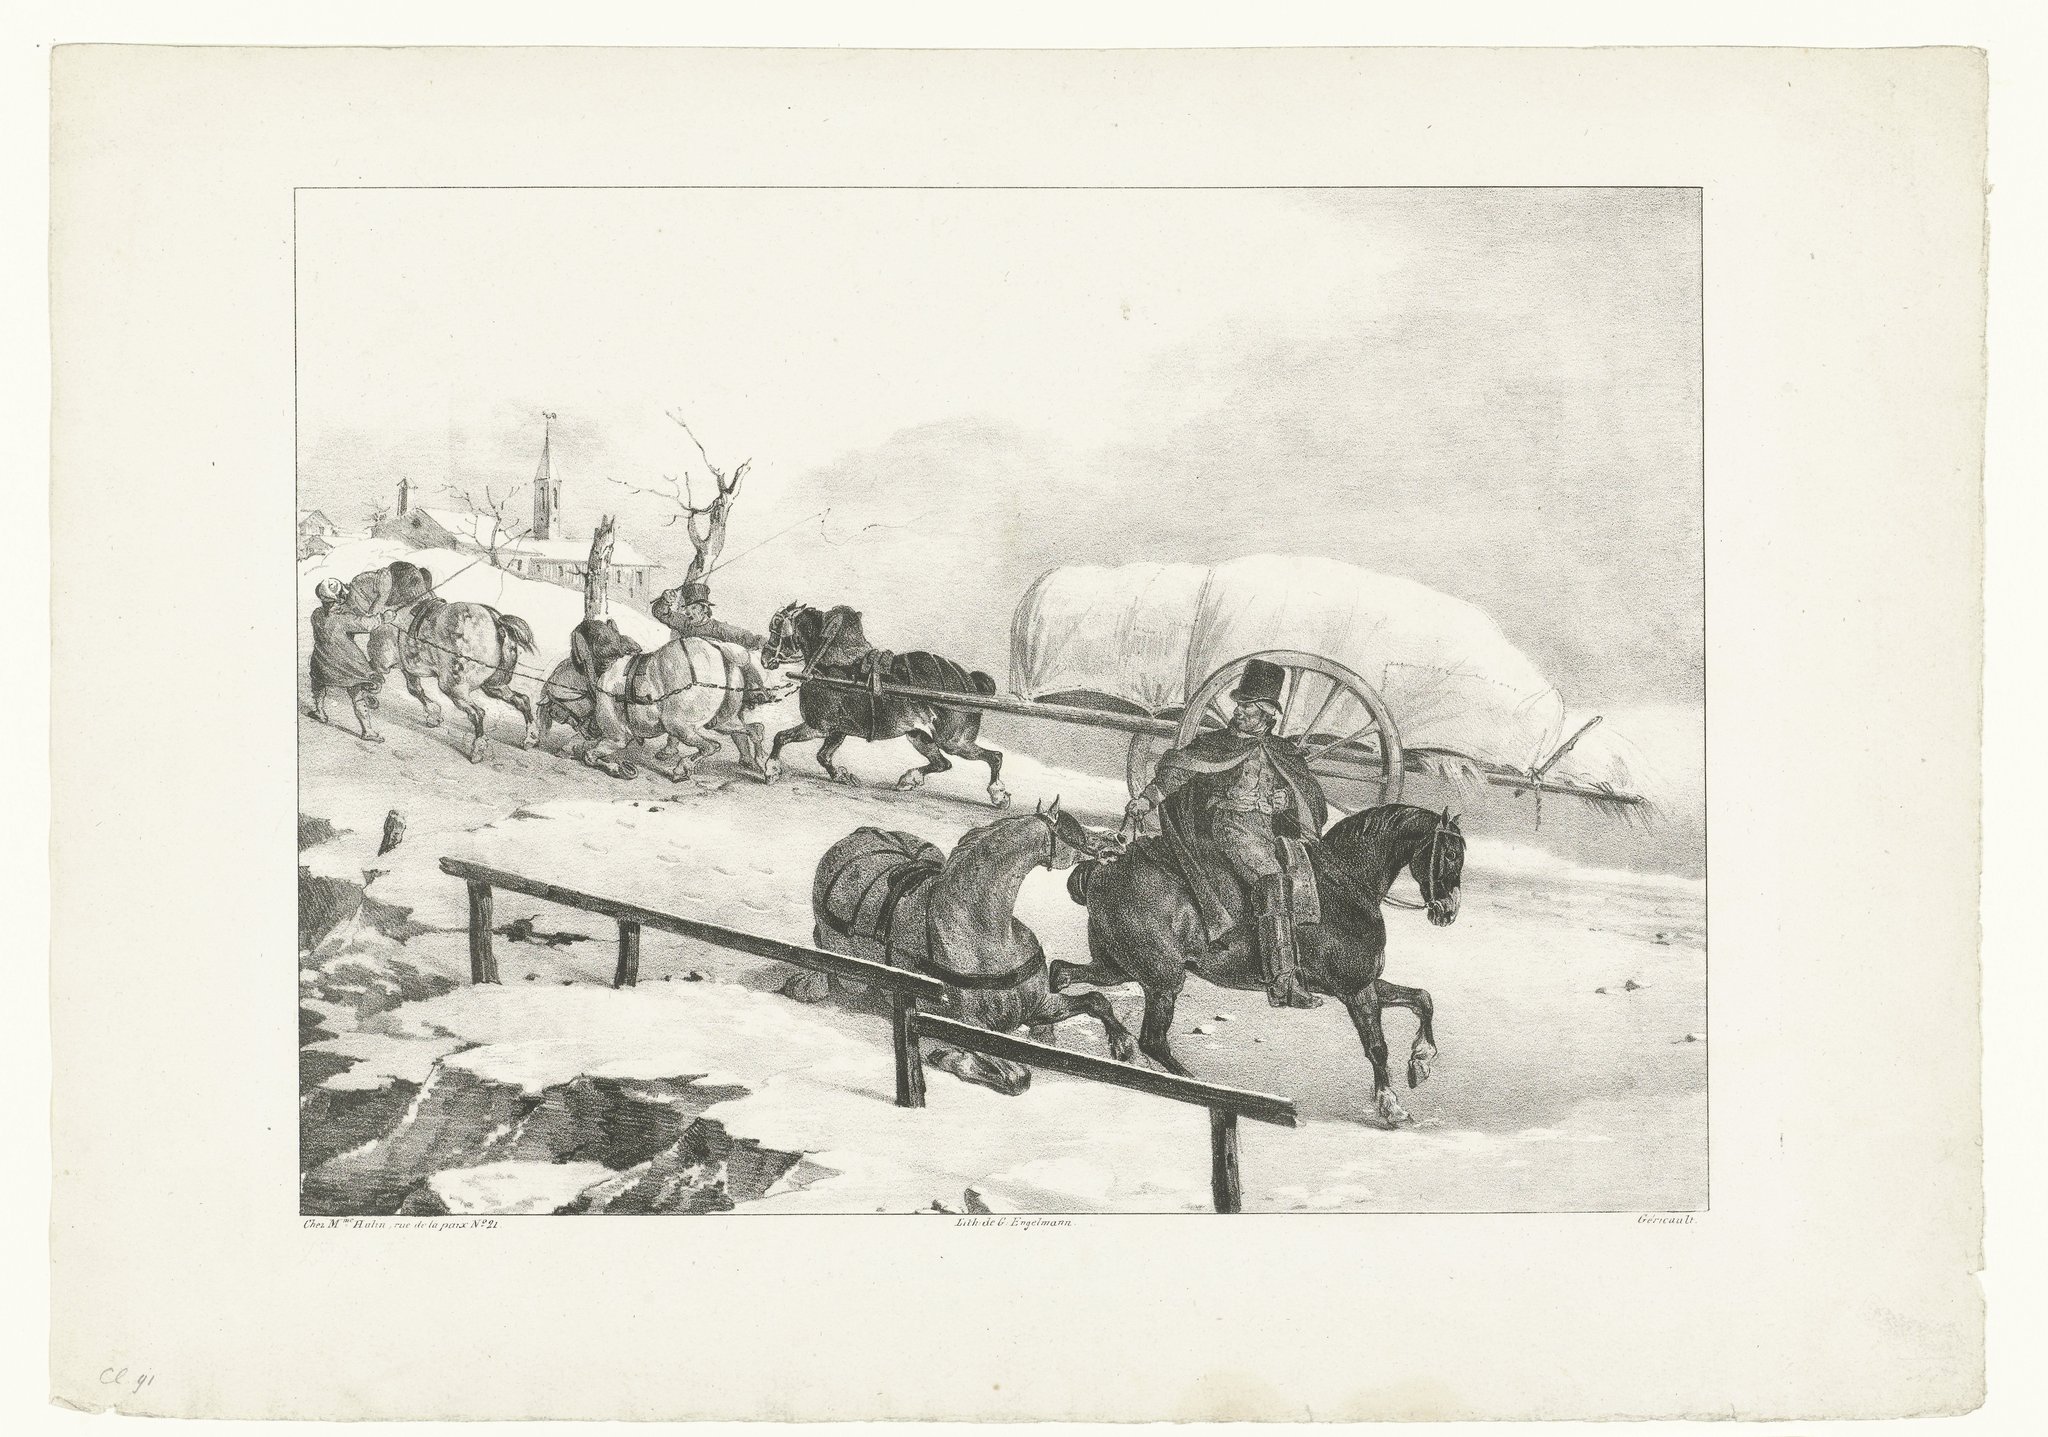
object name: print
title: Quatre Sujets Divers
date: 1823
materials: paper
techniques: lithograph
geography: paris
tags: road, path, snow, horse, (farm) wagon, freight wagon, cart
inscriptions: collector's mark: Lugt 2228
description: Een besneeuwde landweg, een man te paard met een trekpaard aan zijn hand, en een kar met stro getrokken door drie paarden.